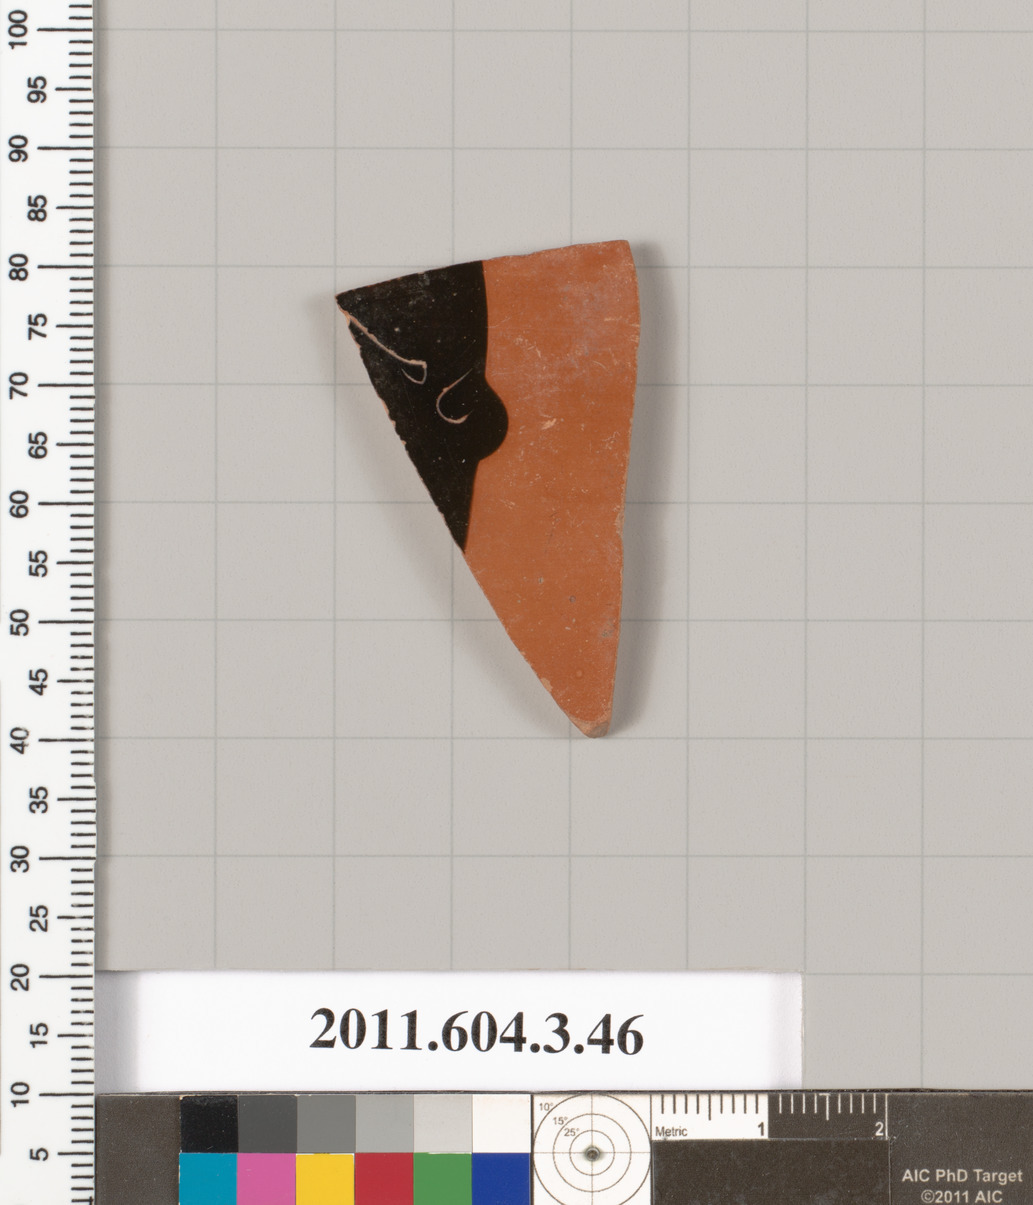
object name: lekythos fragment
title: Terracotta fragment of an lekythos (oil flask)?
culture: greek, attic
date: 534-501 BCE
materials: terracotta